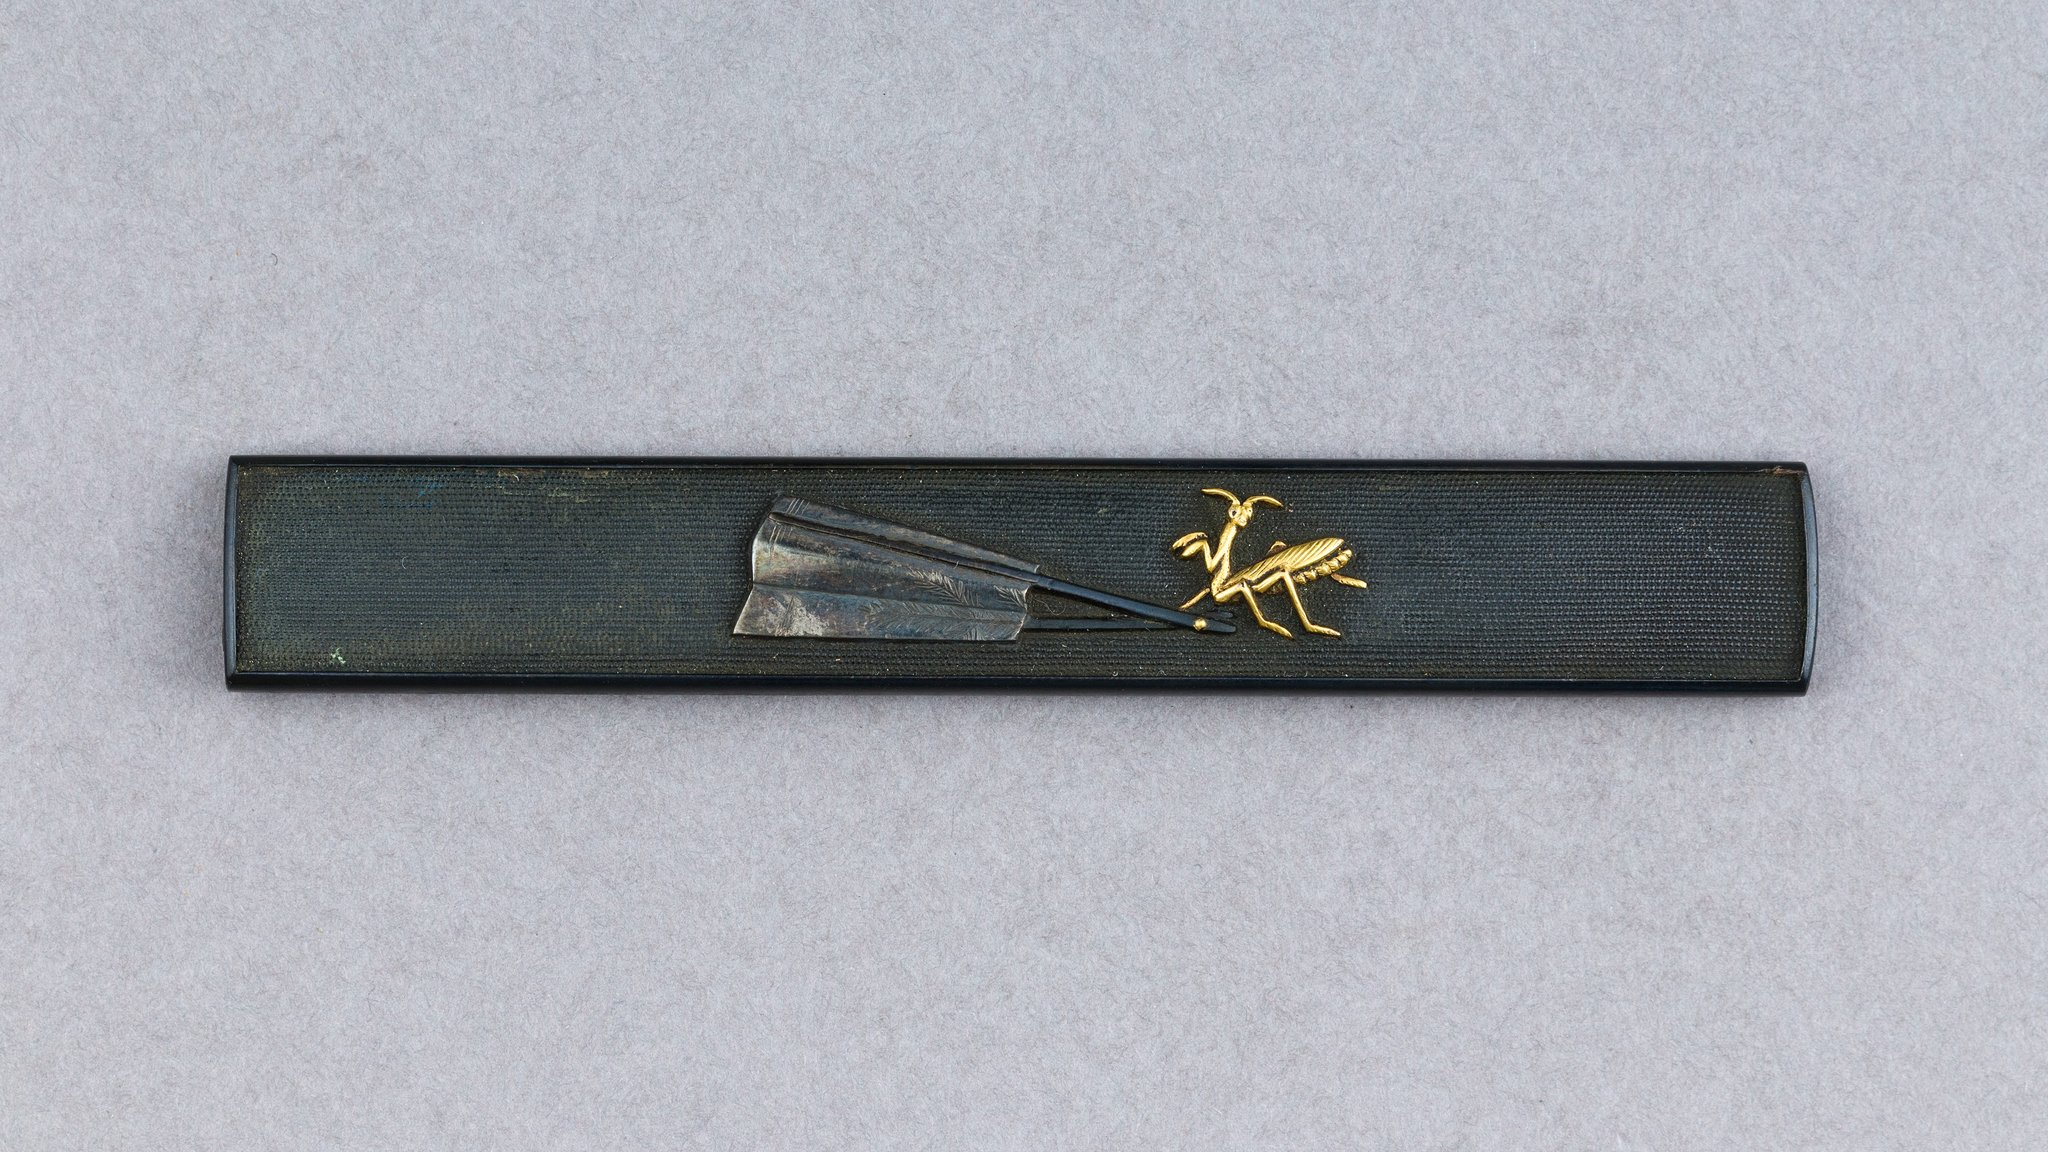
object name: knife handle kozuka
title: Knife Handle (Kozuka)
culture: japanese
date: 1615-1868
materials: gold alloy, gold, silver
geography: japan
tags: insects